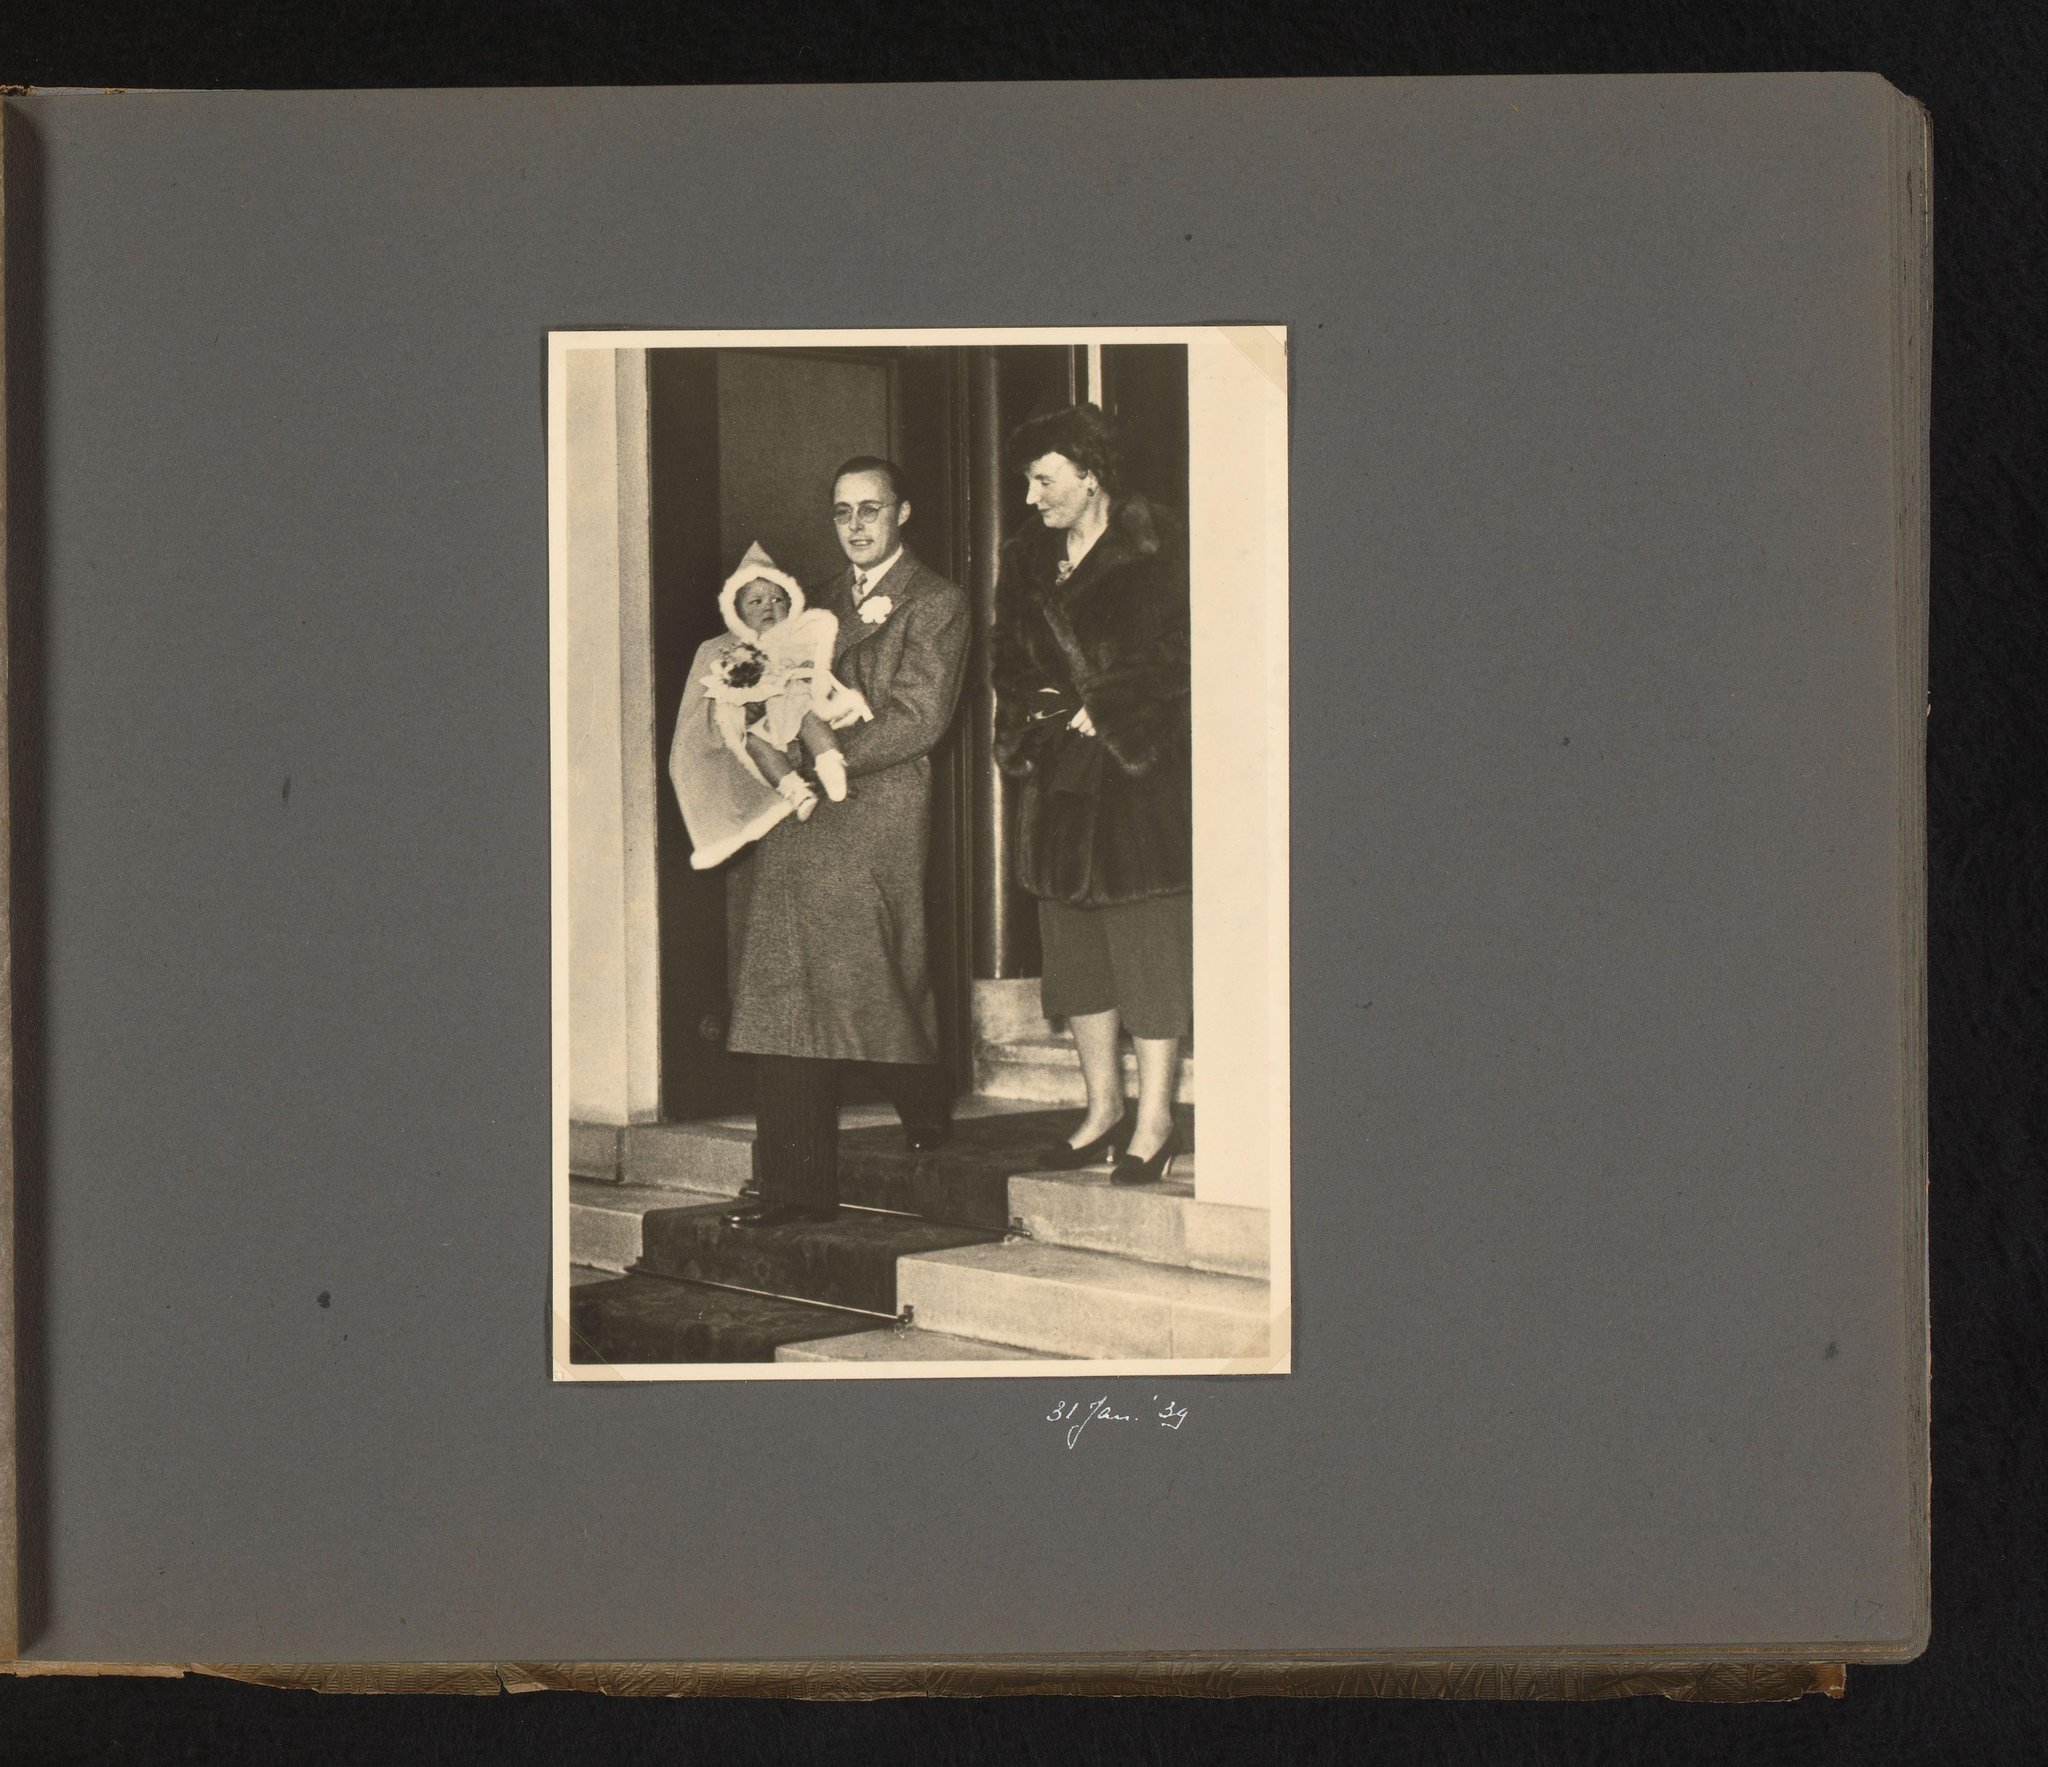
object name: photograph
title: Rijtoer op Prinses Beatrix' eerste verjaardag. 's Gravenhage, 31-1-'39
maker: Anonymous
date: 1939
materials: cardboard, photographic support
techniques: gelatin silver print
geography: the hague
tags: utrecht, bernhard (prins der nederlanden), beatrix (koningin der nederlanden), the hague, juliana of the netherlands, parents with their children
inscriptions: date: ‘31 Jan. '39’, number: ‘289’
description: Albumblad met een foto van prinses Beatrix met haar ouders, bij haar eerste verjaardag op 31 januari 1939. Onderdeel van fotoalbum over het familieleven van de leden van het Koninklijk Huis tussen 1937-1945.